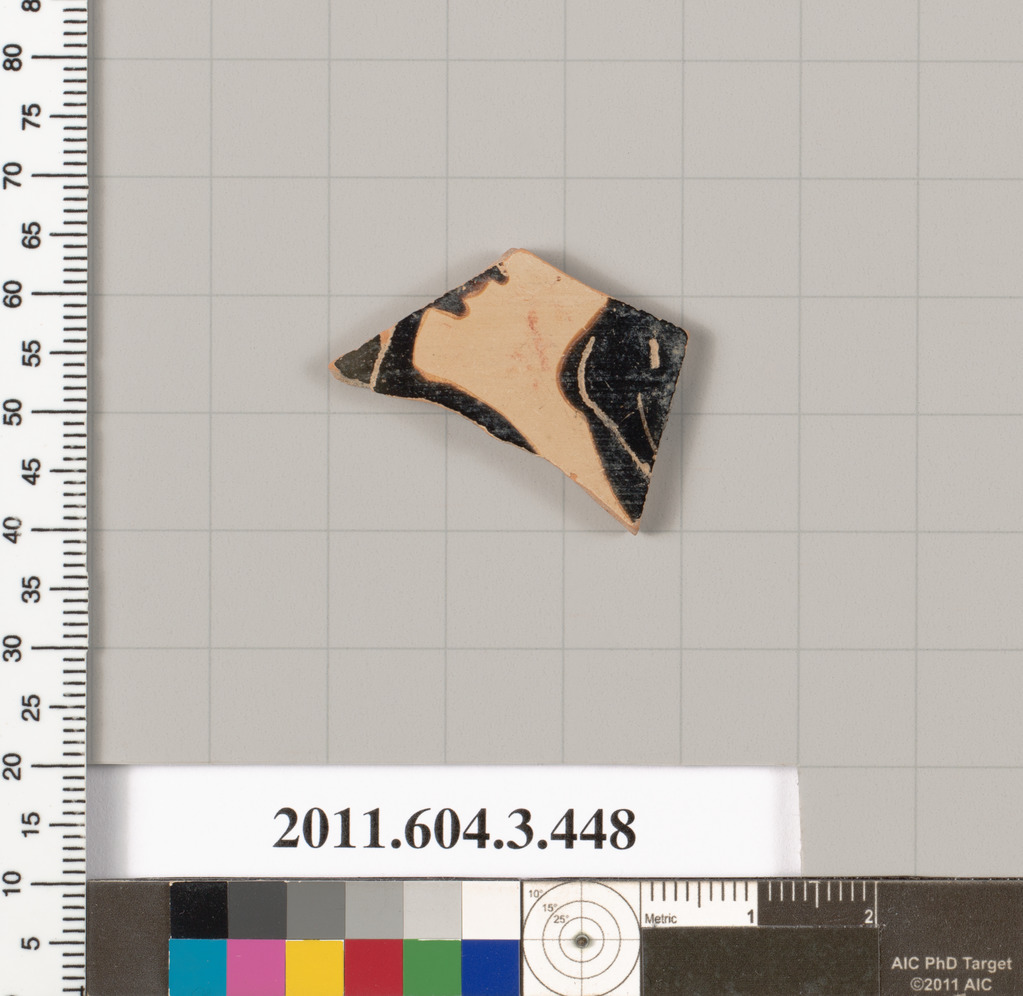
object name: neck amphora fragment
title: Terracotta fragment of a neck-amphora (jar)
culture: greek, attic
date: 490-480 BCE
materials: terracotta